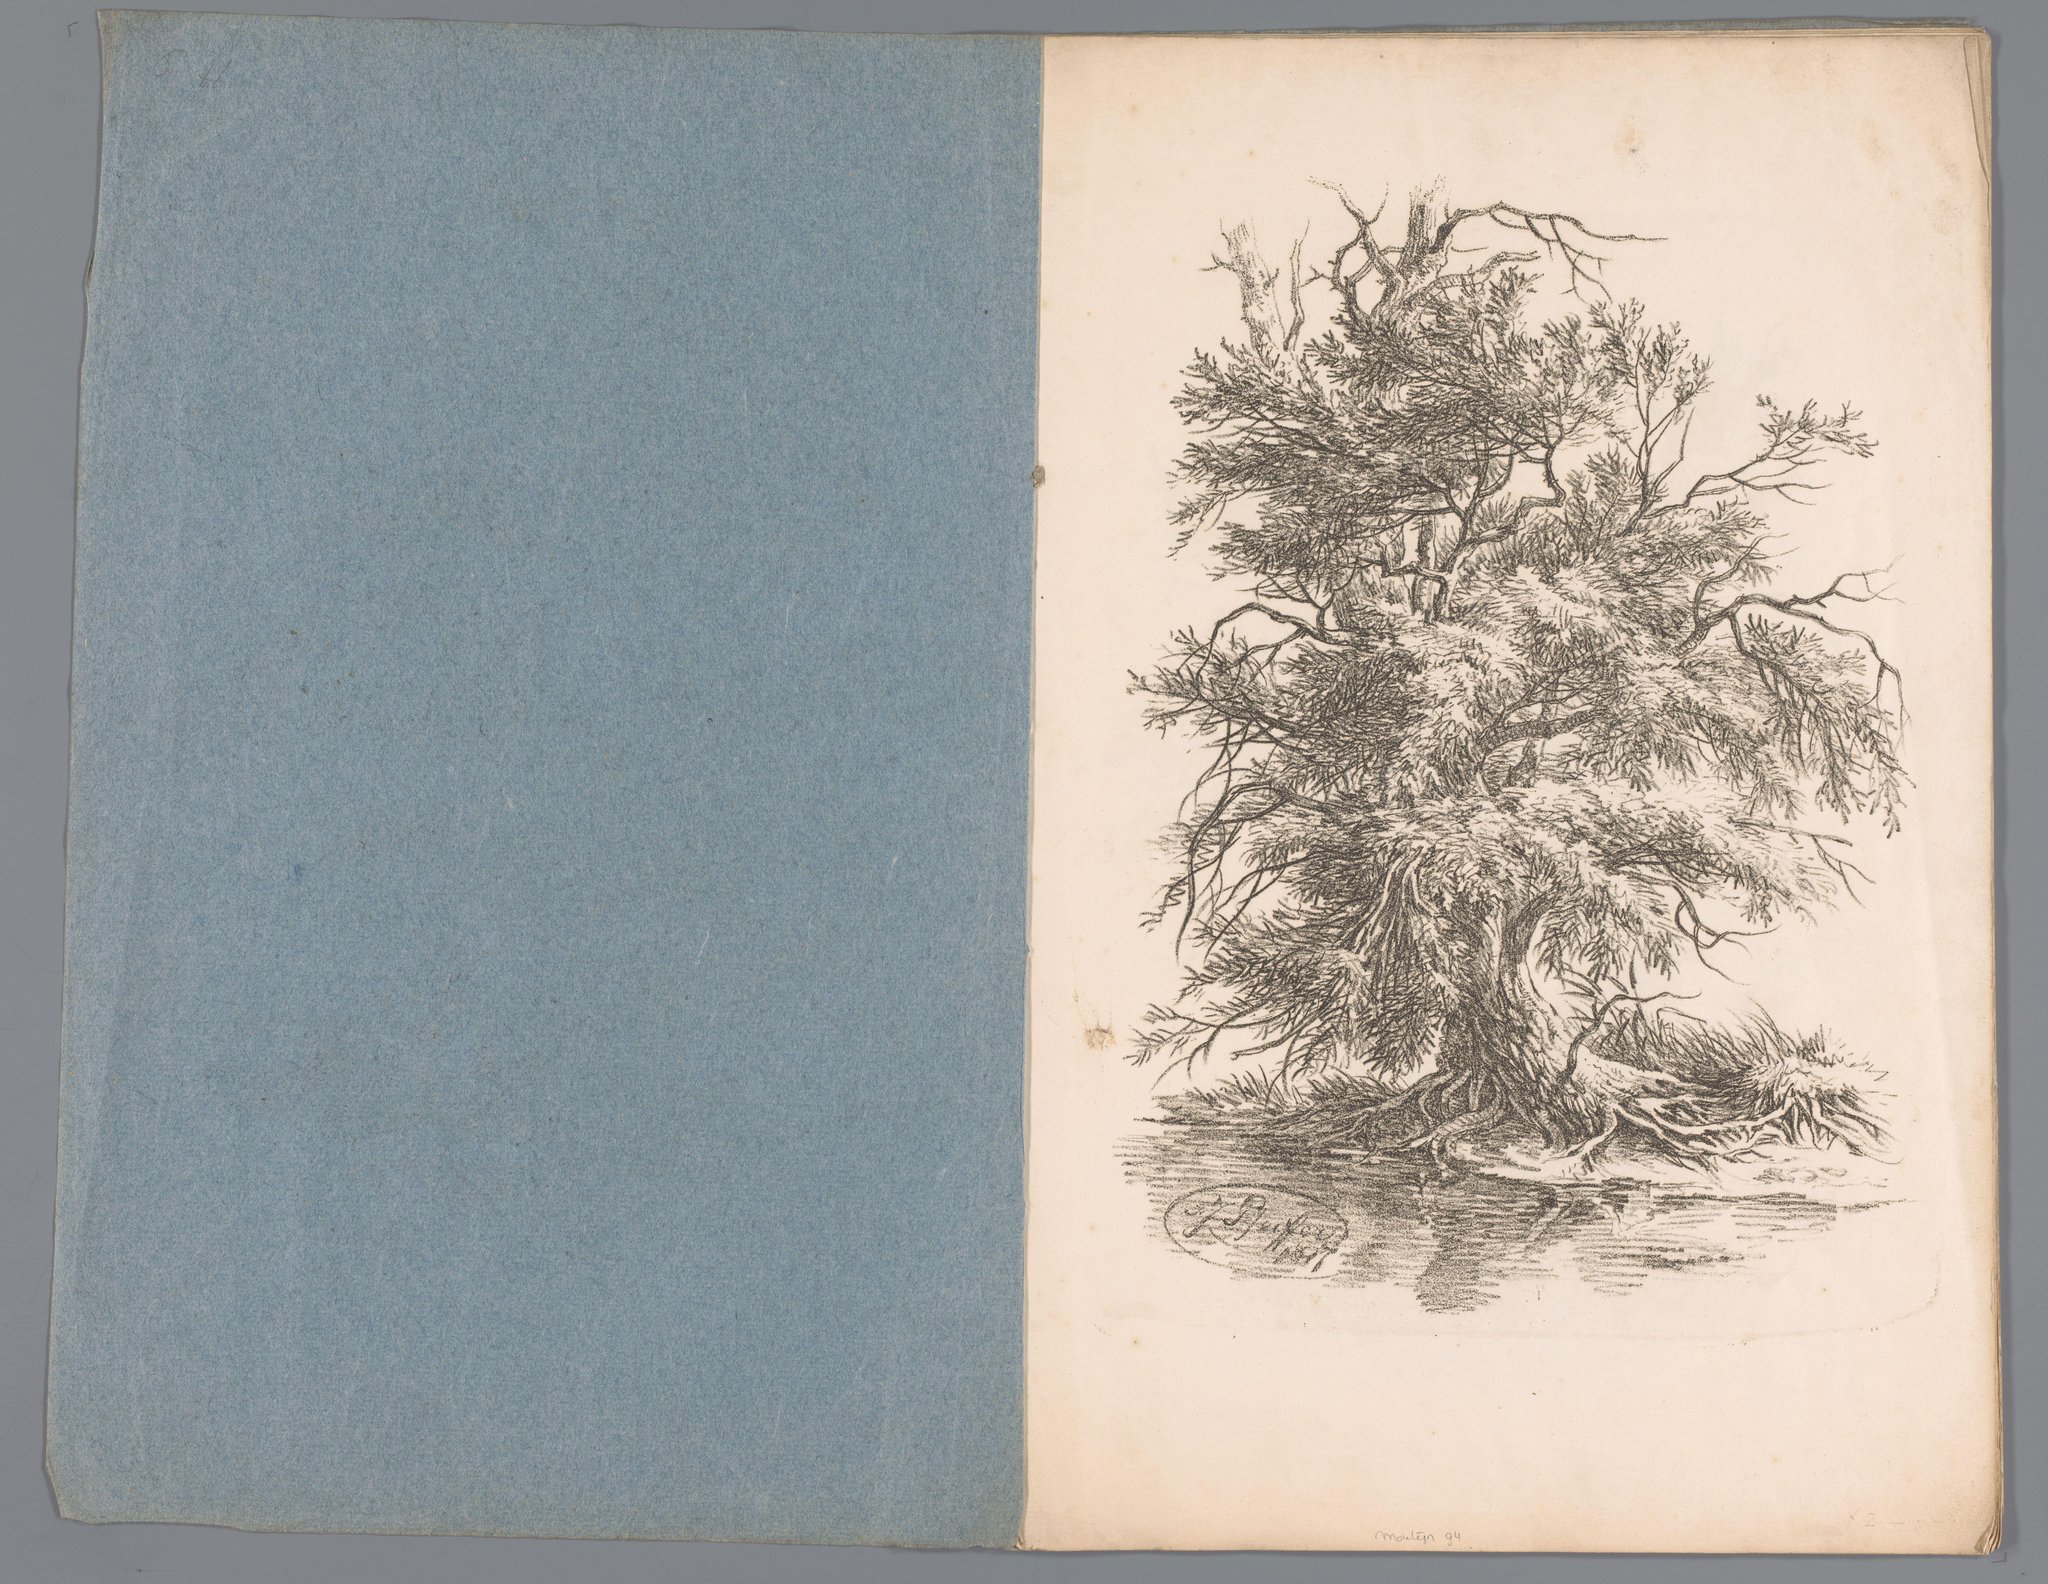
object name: album leaf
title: Etudes du Dessin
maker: françois joseph pfeiffer (ii)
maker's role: draughtsman, print maker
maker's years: 1778-1835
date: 1817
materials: paper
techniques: lithograph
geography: amsterdam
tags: forest, wood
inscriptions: collector's mark: Lugt 2228, signature: ‘F.P. Pfeiffer junior’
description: Boom met gedeeltelijk blootliggende wortels aan een waterkant. Maakt deel uit van een prentalbum met een serie van zes boomstudies.